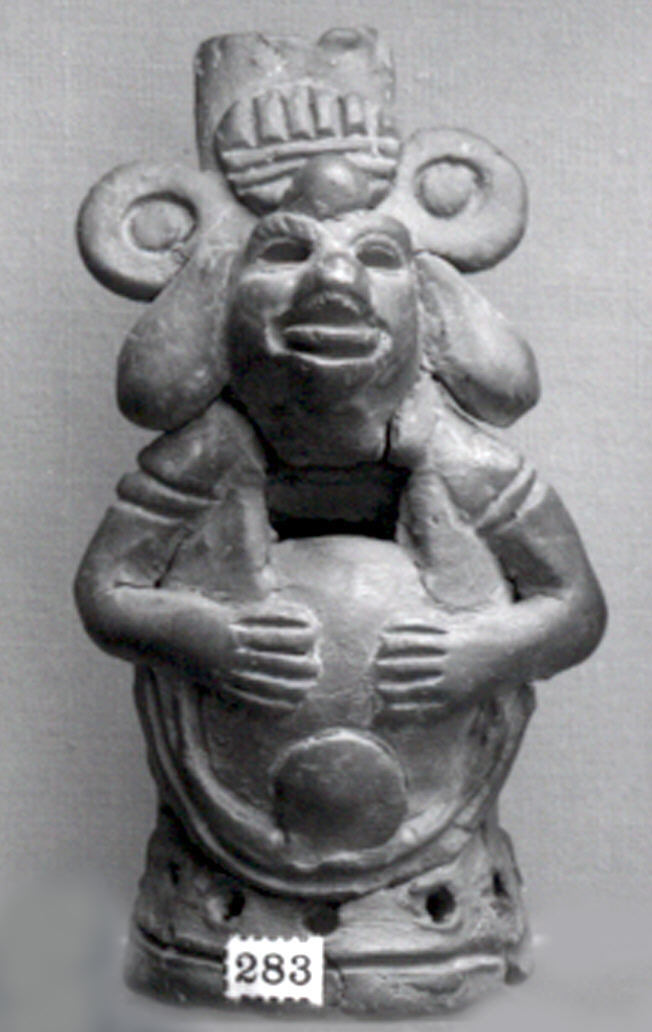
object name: figure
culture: guerrero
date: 1-1500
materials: terracotta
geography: mexico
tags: human figures